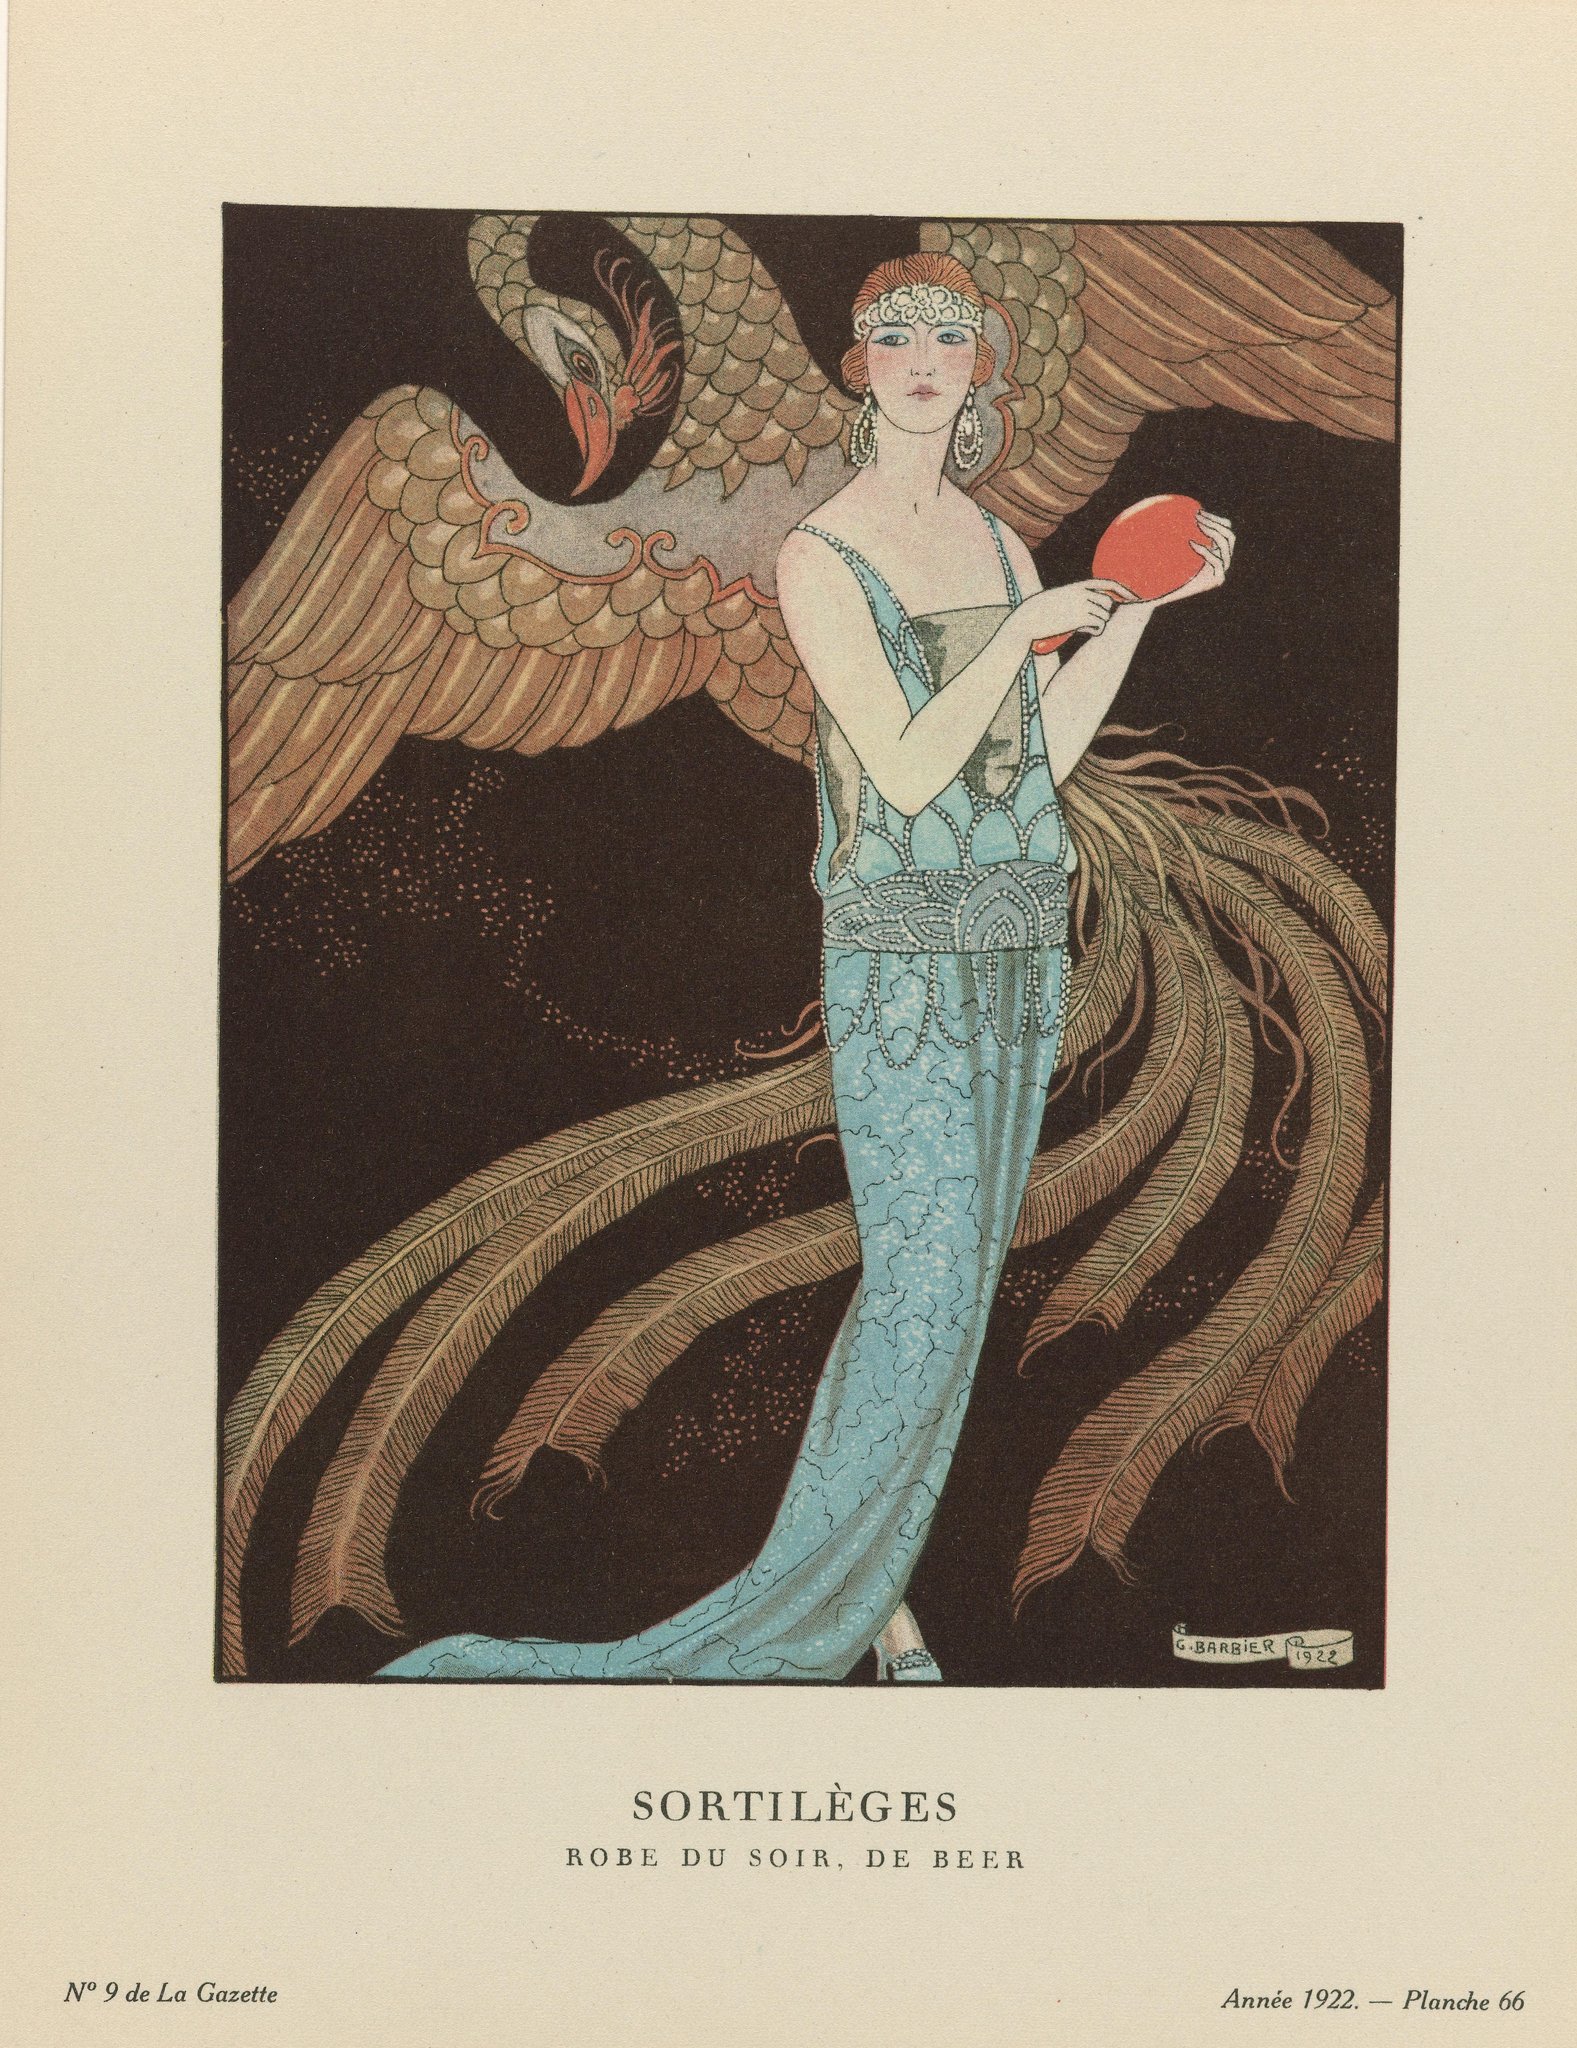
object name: fashion print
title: Gazette du Bon Ton, 1922 - No. 9 : Sortilèges / Robe du soir, de Beer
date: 1922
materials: paper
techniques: printing, letterpress printing, photochemical processes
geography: london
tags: diadem, tiara (+ women's clothes), dress, gown: evening dress (+ women's clothes), mirror, fashion plates, fabulous animals ~ birds: phoenix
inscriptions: date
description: Staande vrouw met een handspiegel in de handen, gekleed in een avondjapon met diamanten van Beer. In de oren oorbellen. In het haar een diadeem. Op de achtergrond een phoenix. Planche 66 uit Gazette du Bon Ton 1922, No. 9. Uitleg over de kleding op pagina "Description et explication des planches hors-texte et pages de croquis."